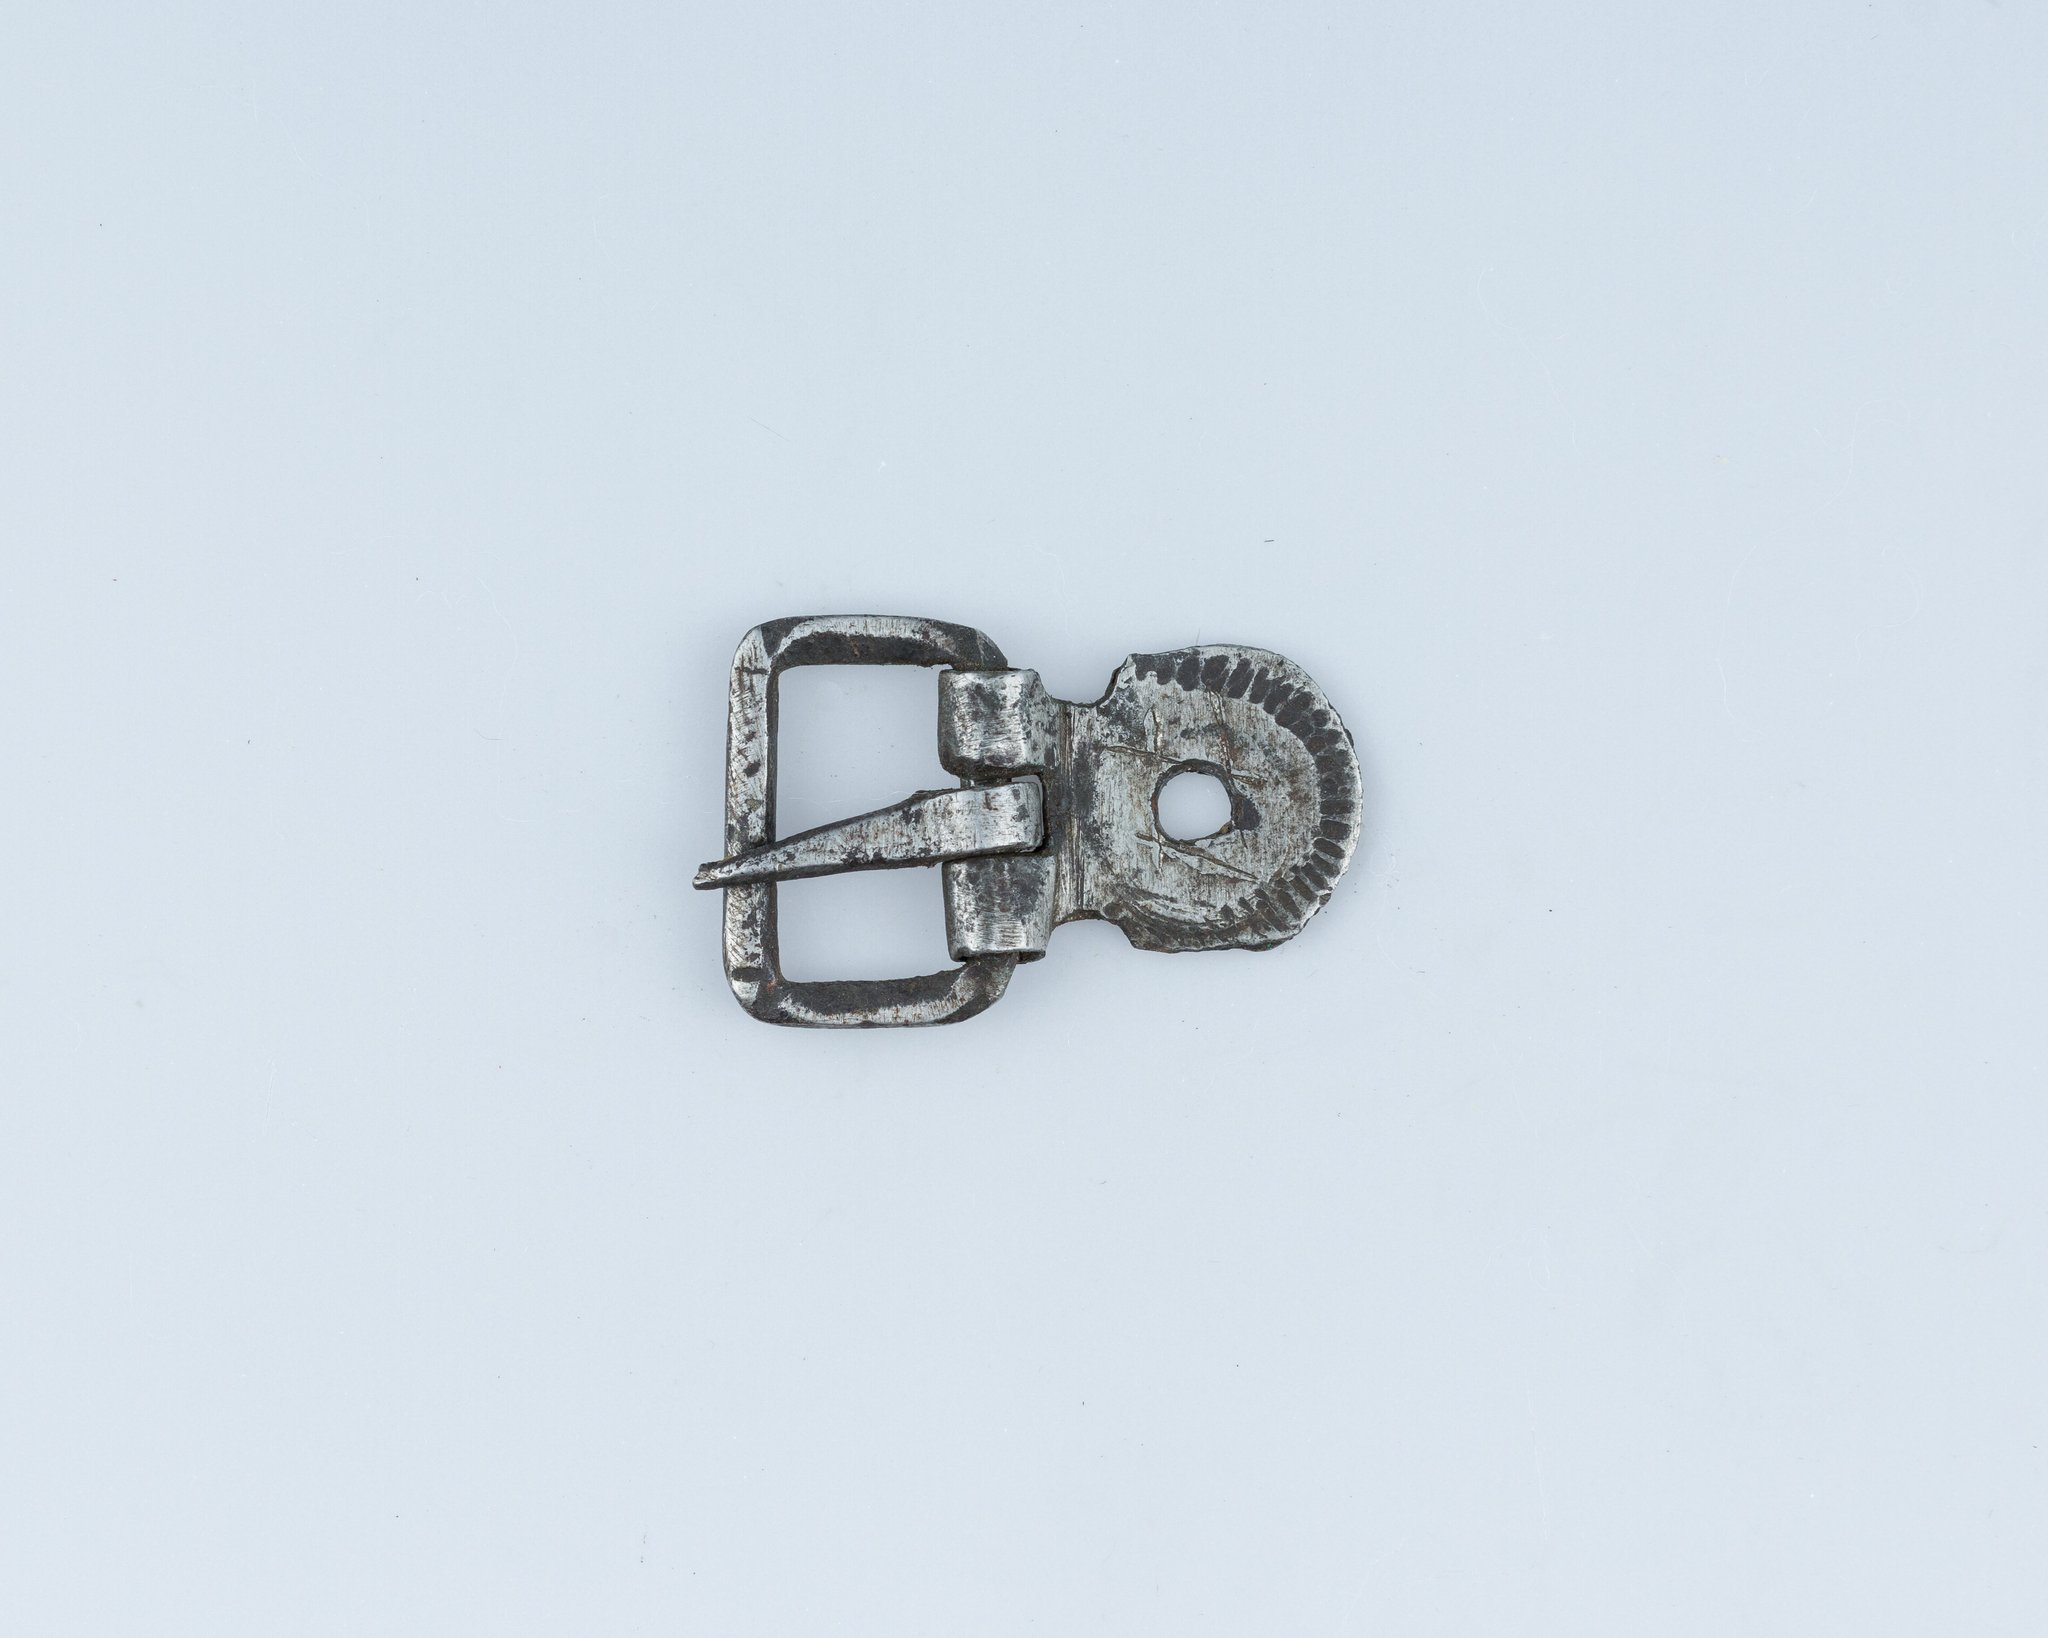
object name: buckle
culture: german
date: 1490-1510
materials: steel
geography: germany